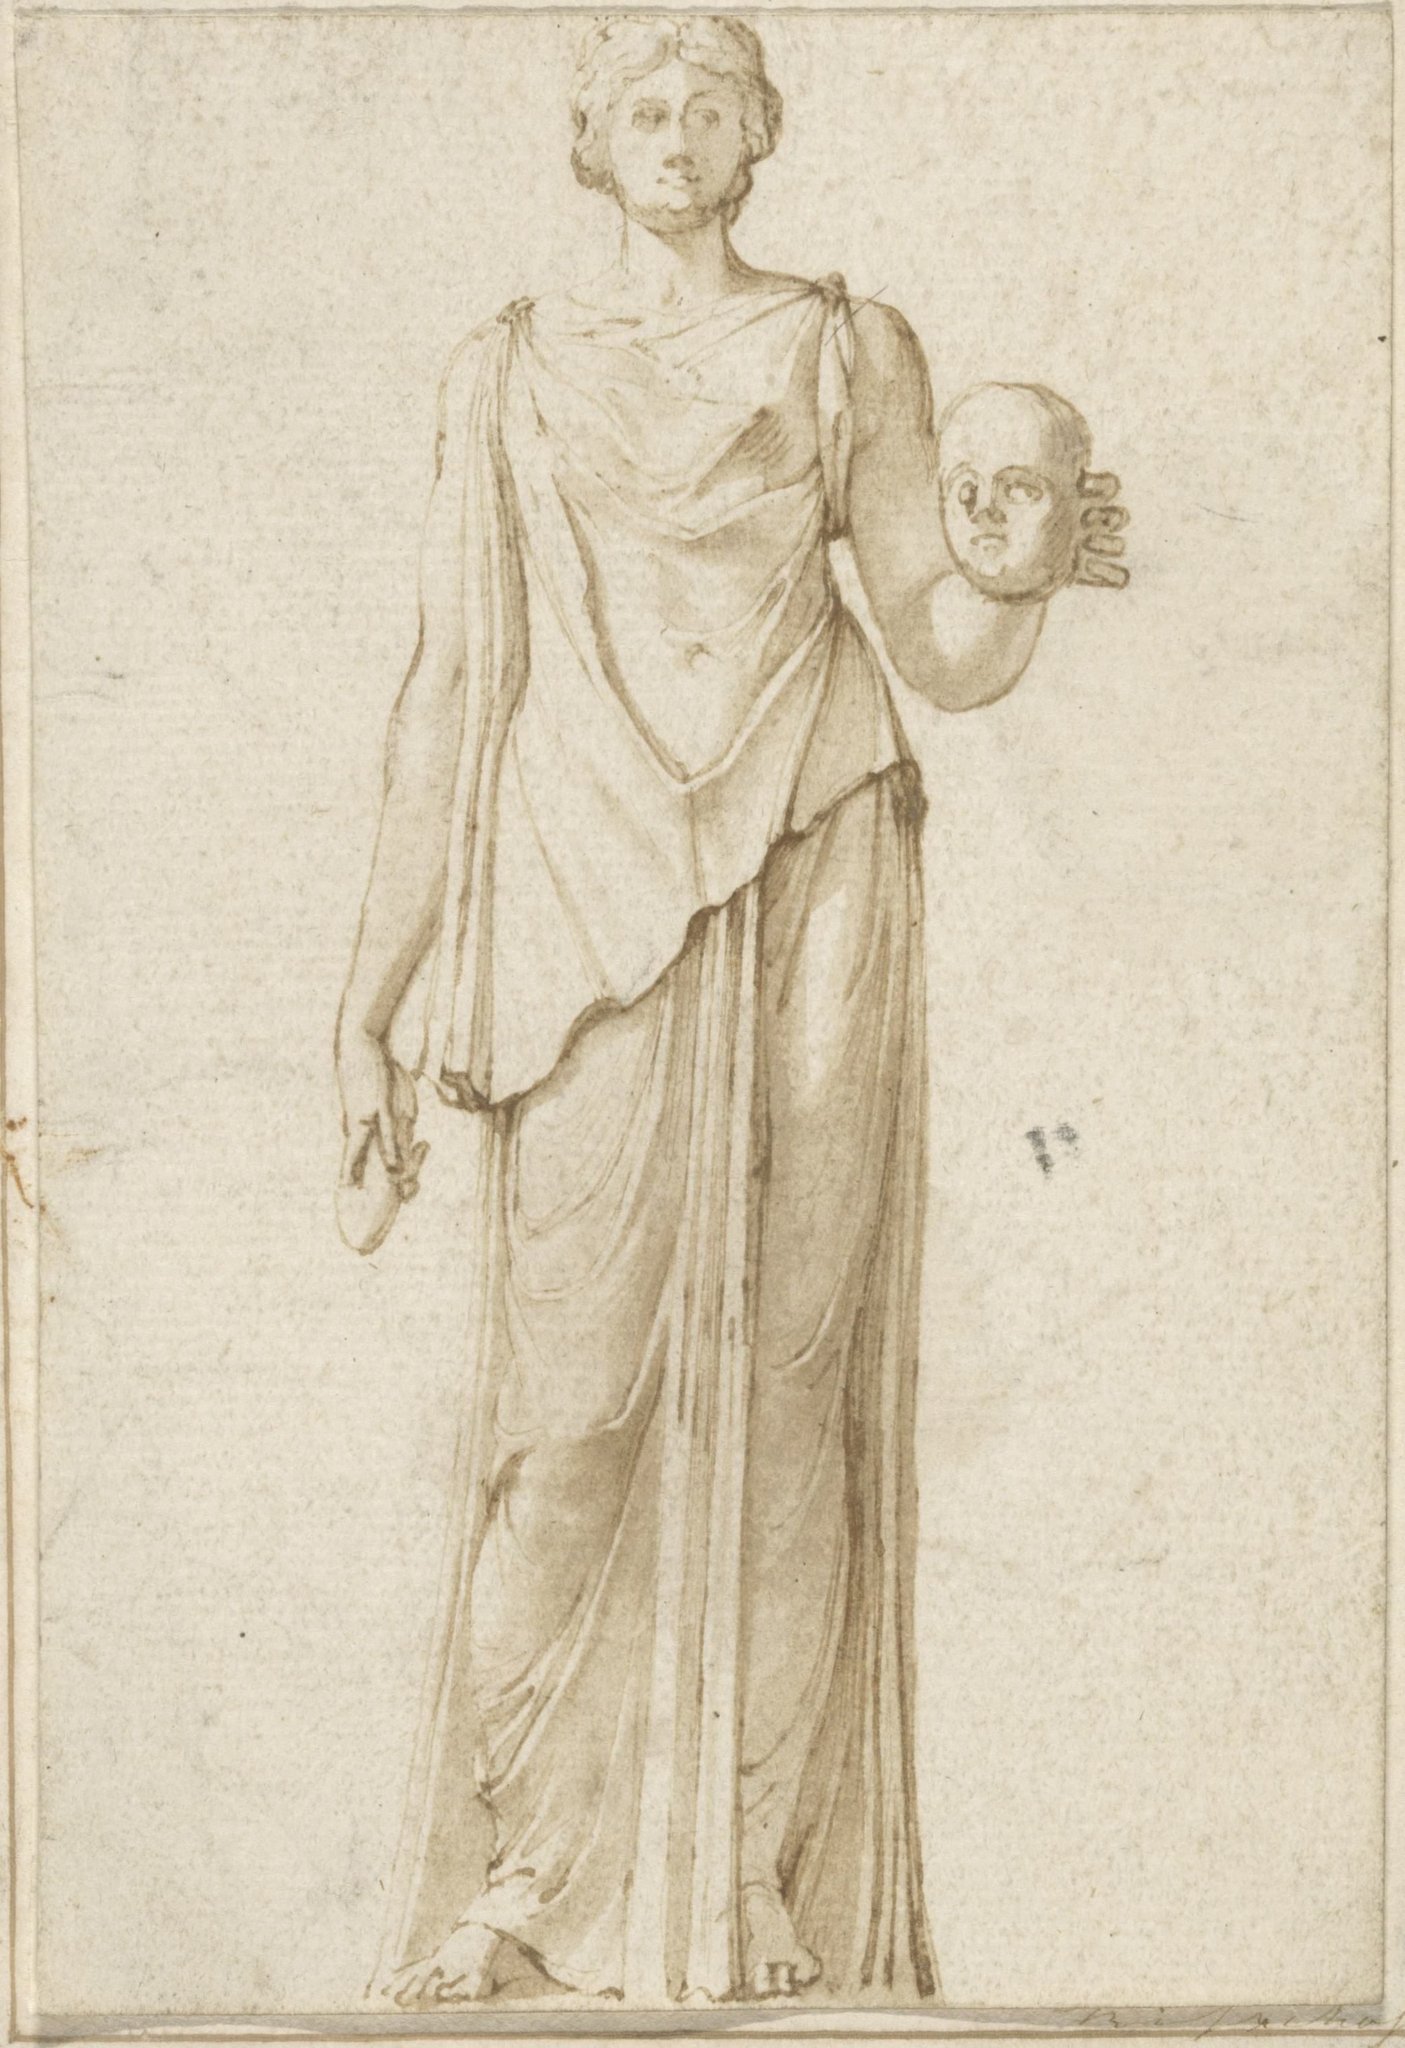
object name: drawing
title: De muze Thalia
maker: jan de bisschop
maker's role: draughtsman, print maker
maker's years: 1628-1671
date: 1600-1780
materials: ink, paper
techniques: brush, pen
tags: thalia (one of the muses); 'talia' (ripa)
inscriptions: inscription: ‘Bisschop’